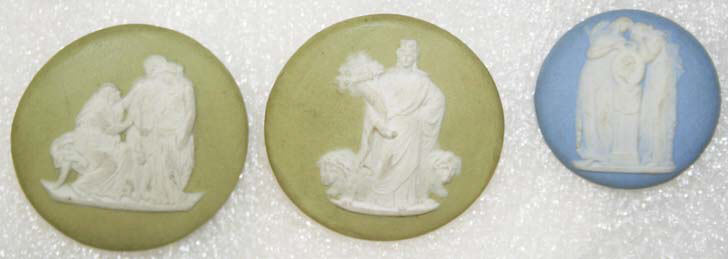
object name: button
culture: british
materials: jasper, metal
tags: cameos,men,women